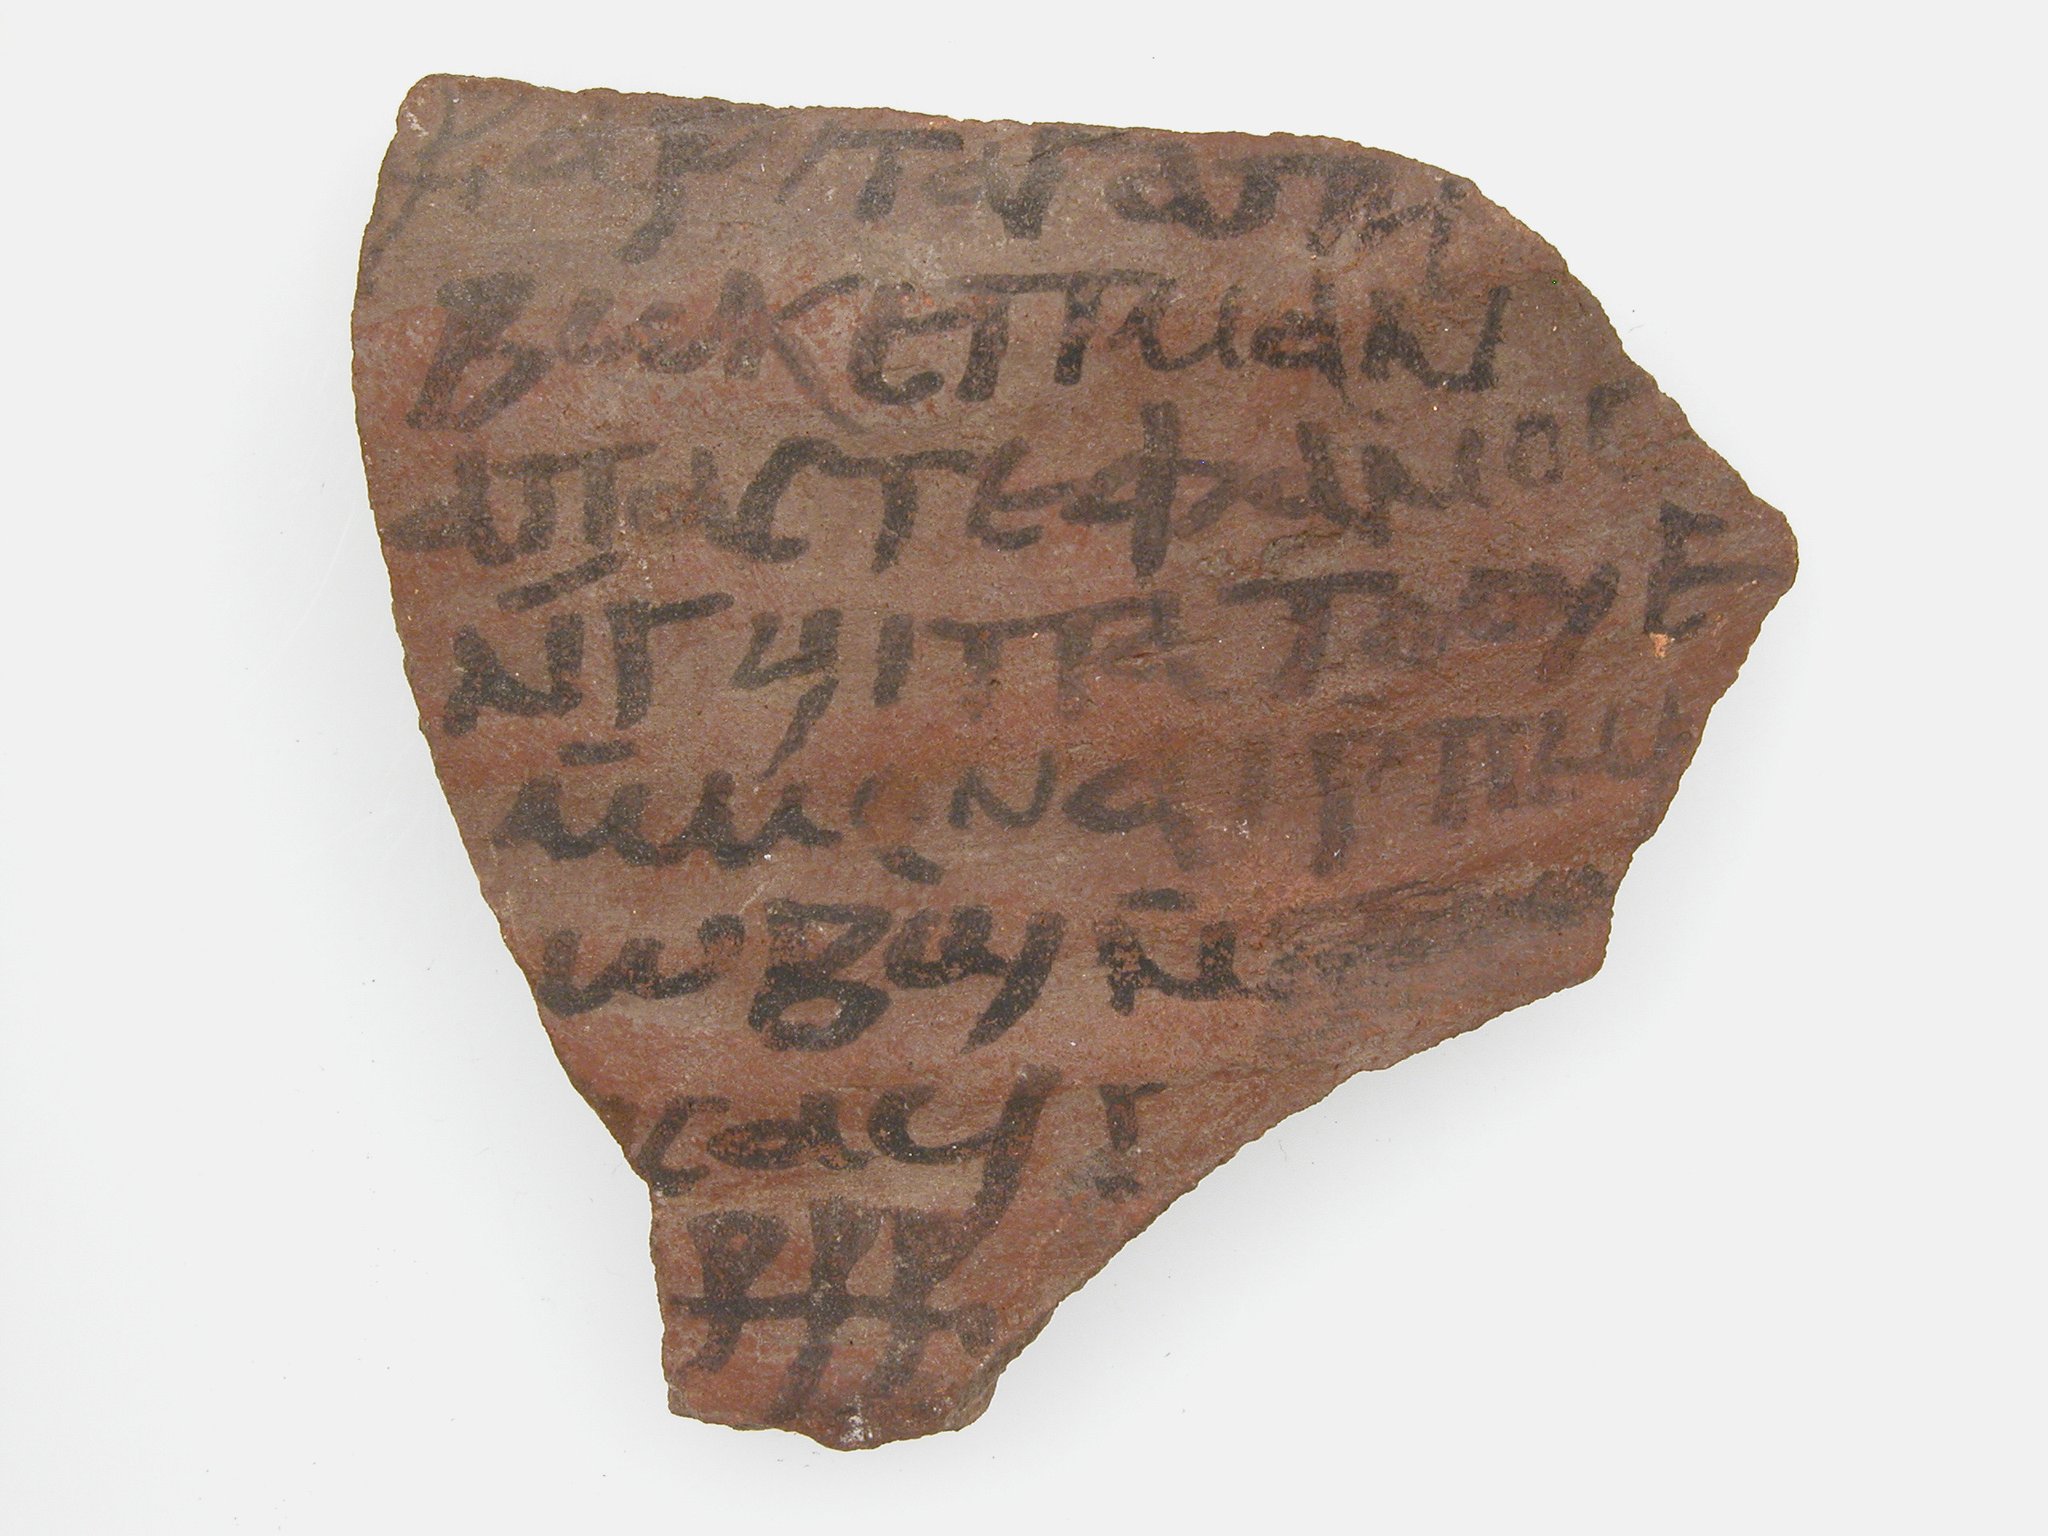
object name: ostrakon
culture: coptic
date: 601-700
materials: ink, pottery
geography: egypt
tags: coptic